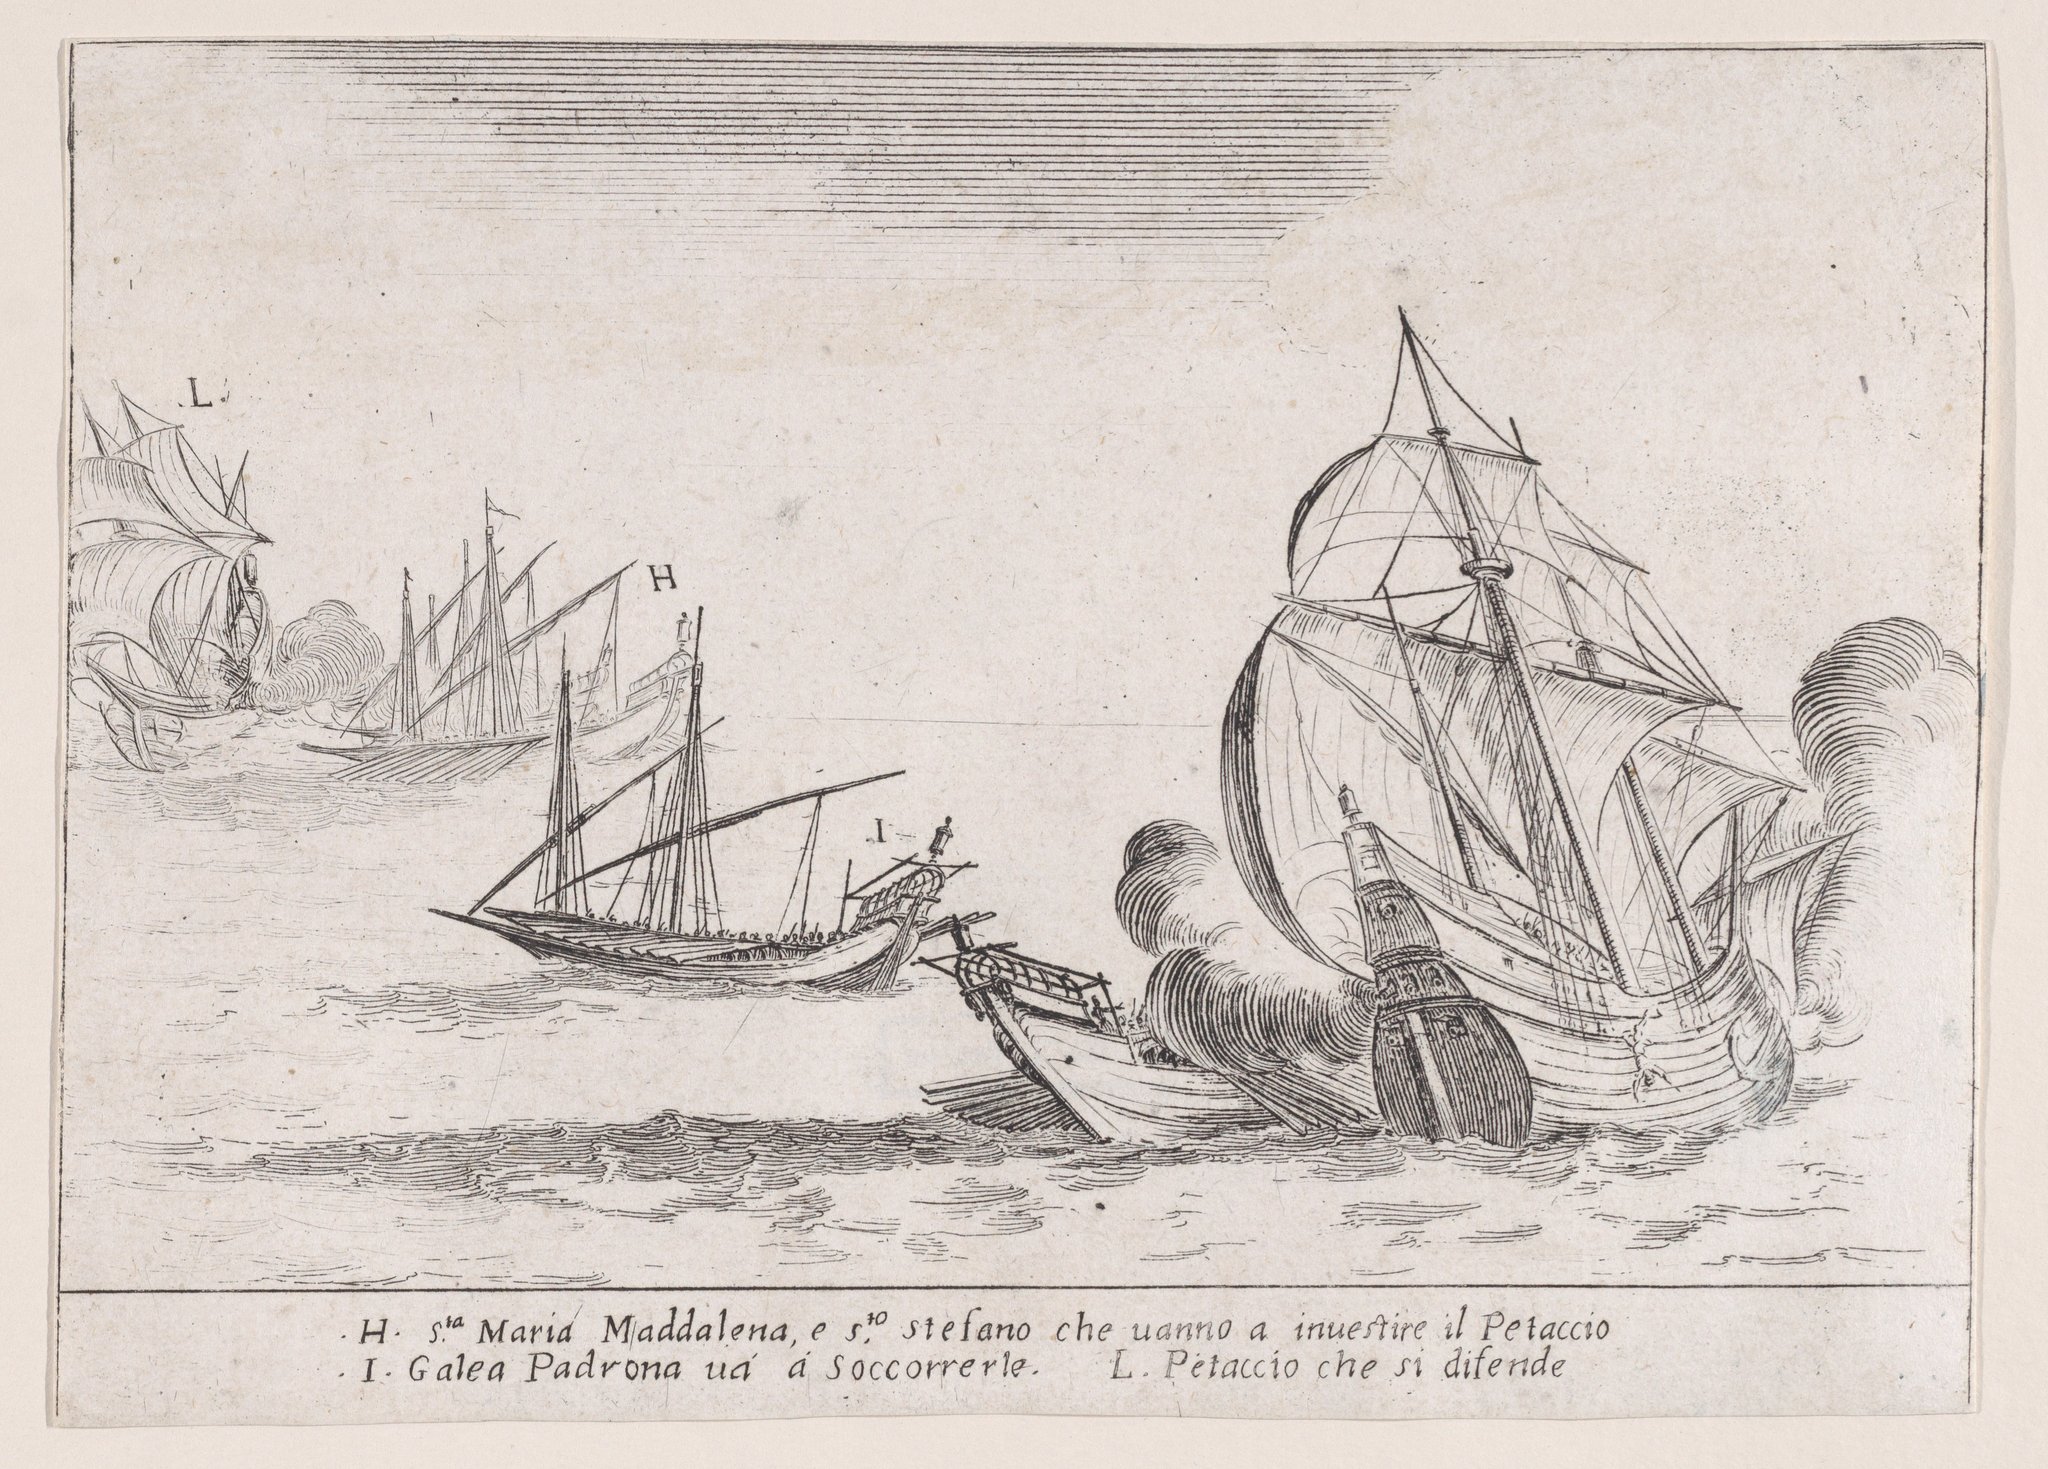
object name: print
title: L'Abordage du Taccio (The Collision of Taccio), from "Les Combats de Quatre Galères" (The Battles of Four Galleys)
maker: jacques callot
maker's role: artist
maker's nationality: french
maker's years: 1592-1635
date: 1601-1633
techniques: etching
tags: battles,ships